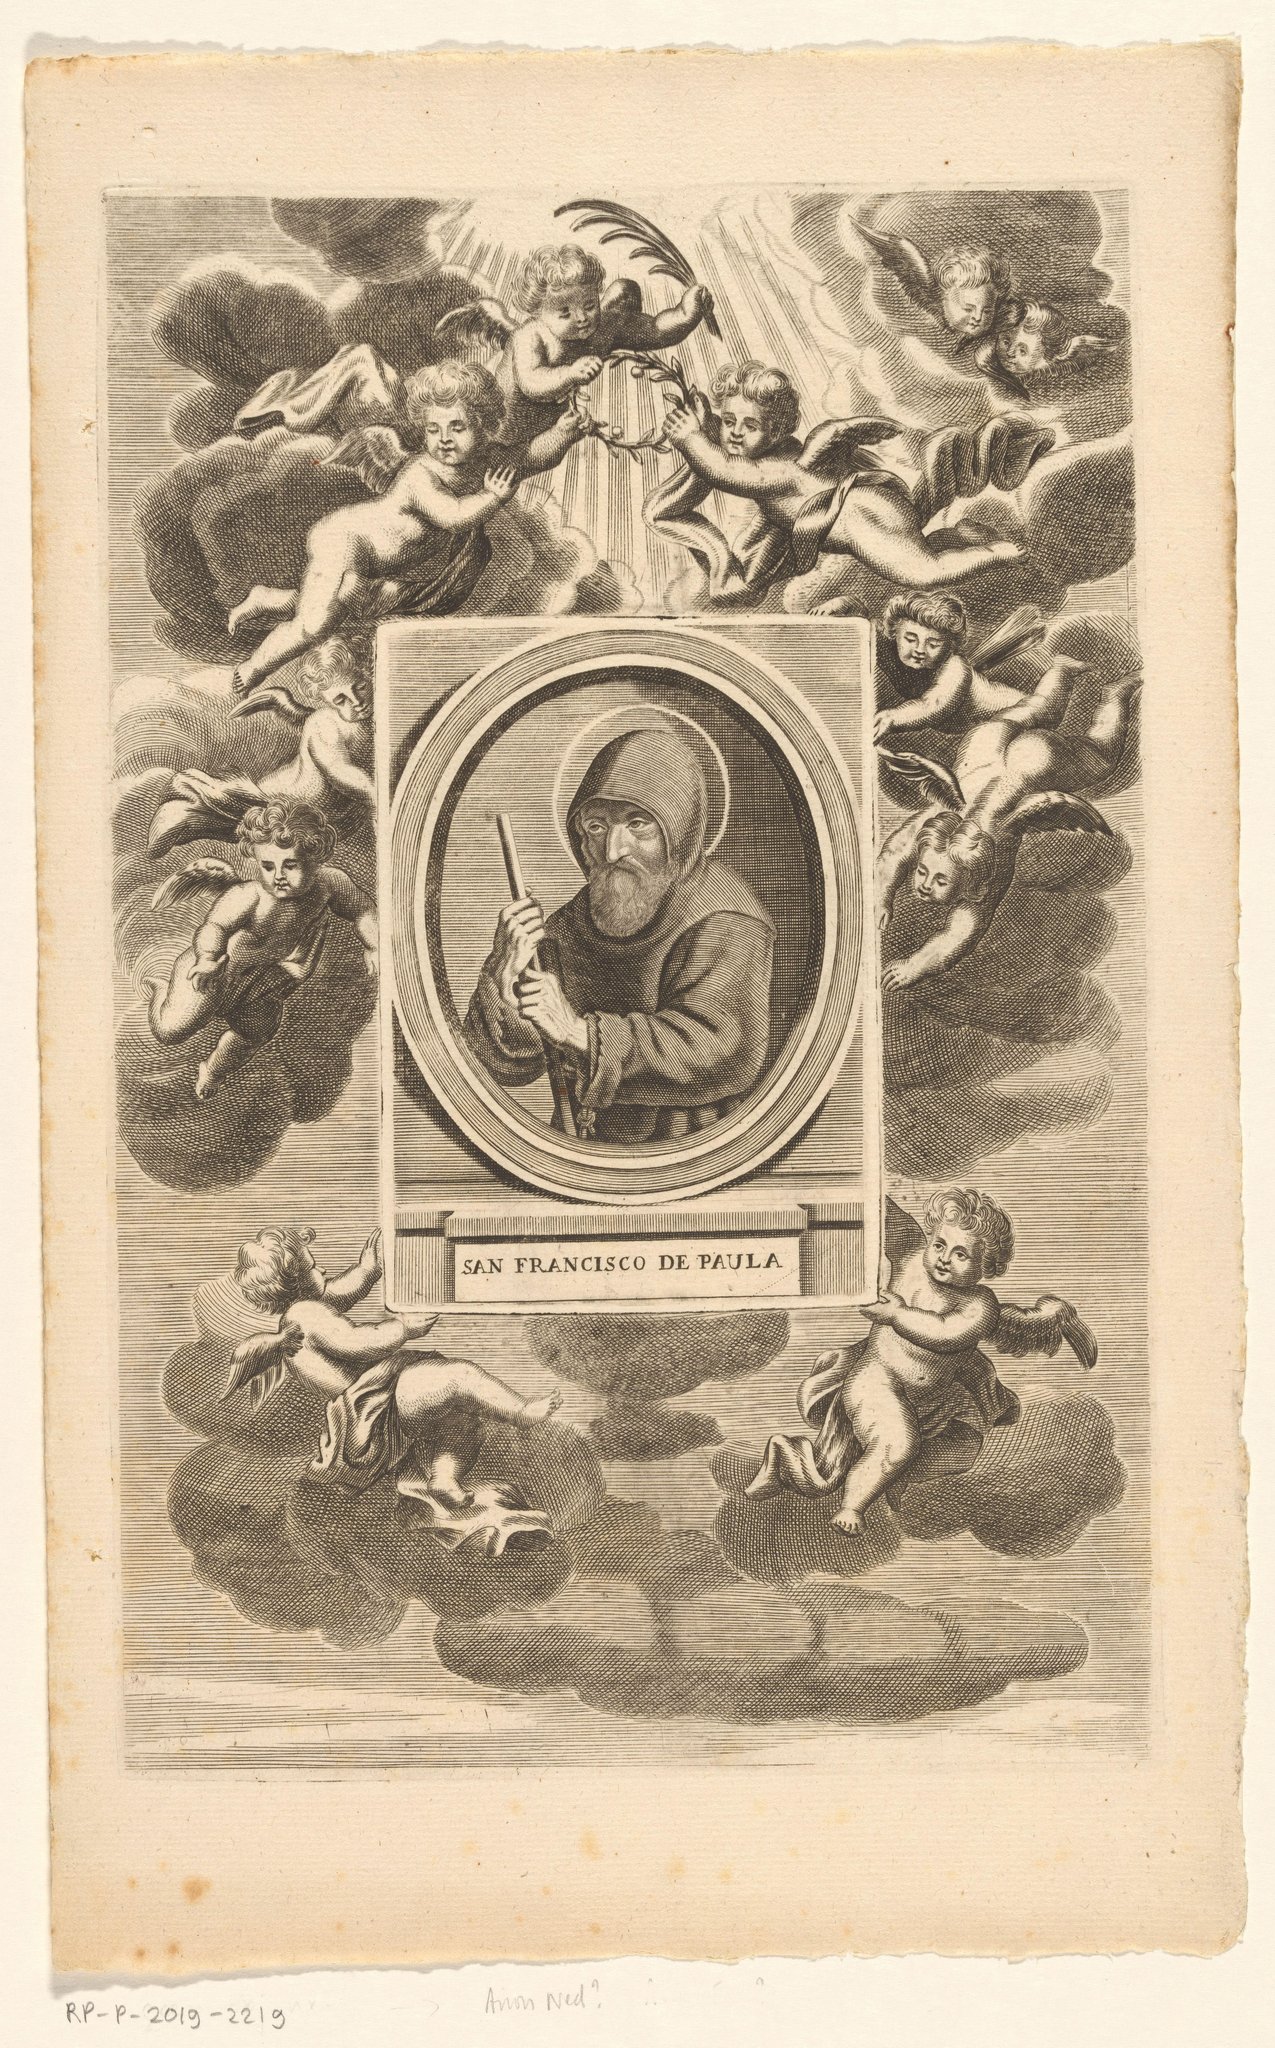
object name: print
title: San Francisco de Paula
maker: Anonymous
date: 1650-1750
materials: paper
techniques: engraving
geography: netherlands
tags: the hermit and founder of the (franciscan) minim friars, francis of paola; possible attributes: inscription 'charitas' on breast, discipline, skull, staff, angels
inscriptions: collector's mark: Lugt 2228